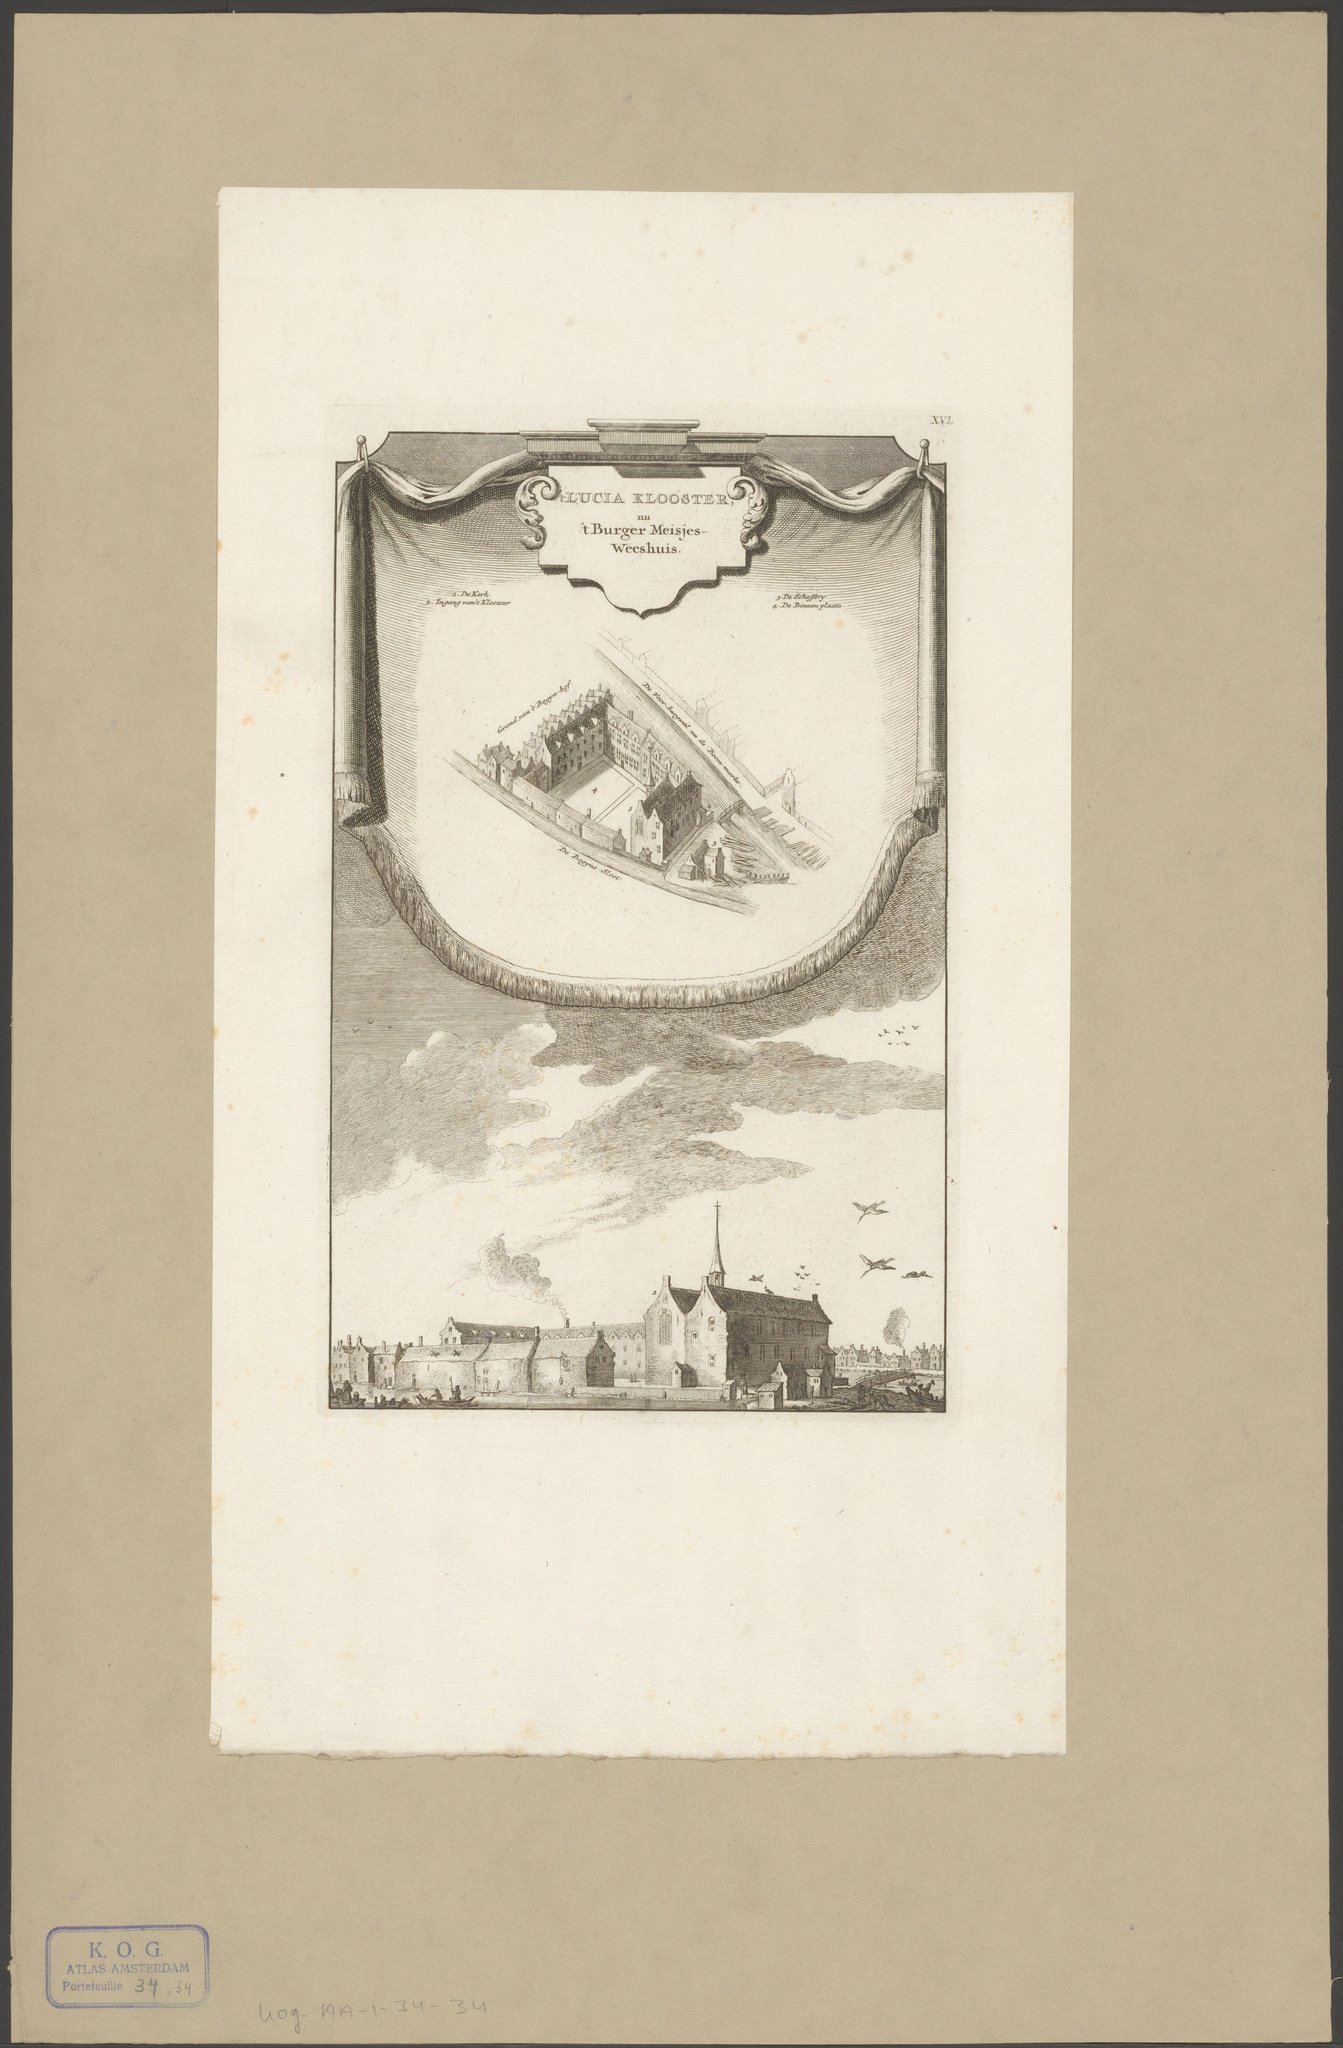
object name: print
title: Gezichten op het Sint-Luciënklooster te Amsterdam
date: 1760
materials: paper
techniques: engraving, etching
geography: amsterdam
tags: abbey, monastery, convent ~ roman catholic church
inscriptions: collector's mark: Lugt 1641b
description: Prent mogelijk uit: Wagenaar, Jan. Amsterdam, in zyne opkomst, aanwas, geschiedenissen (…). Amsterdam: Isaak Tirion, 1760, dl. 1. Dat de prent de situatie rond 1544 weergeeft, gaat terug op het feit dat voor het maken van deze en andere prenten van kloosters en kerken van voor de Alteratie (1578) is uitgegaan van de plattegrond van Cornelis Anthonisz. uit 1544, zie RP-P-OB-70.399 en RP-P-AO-20-15.